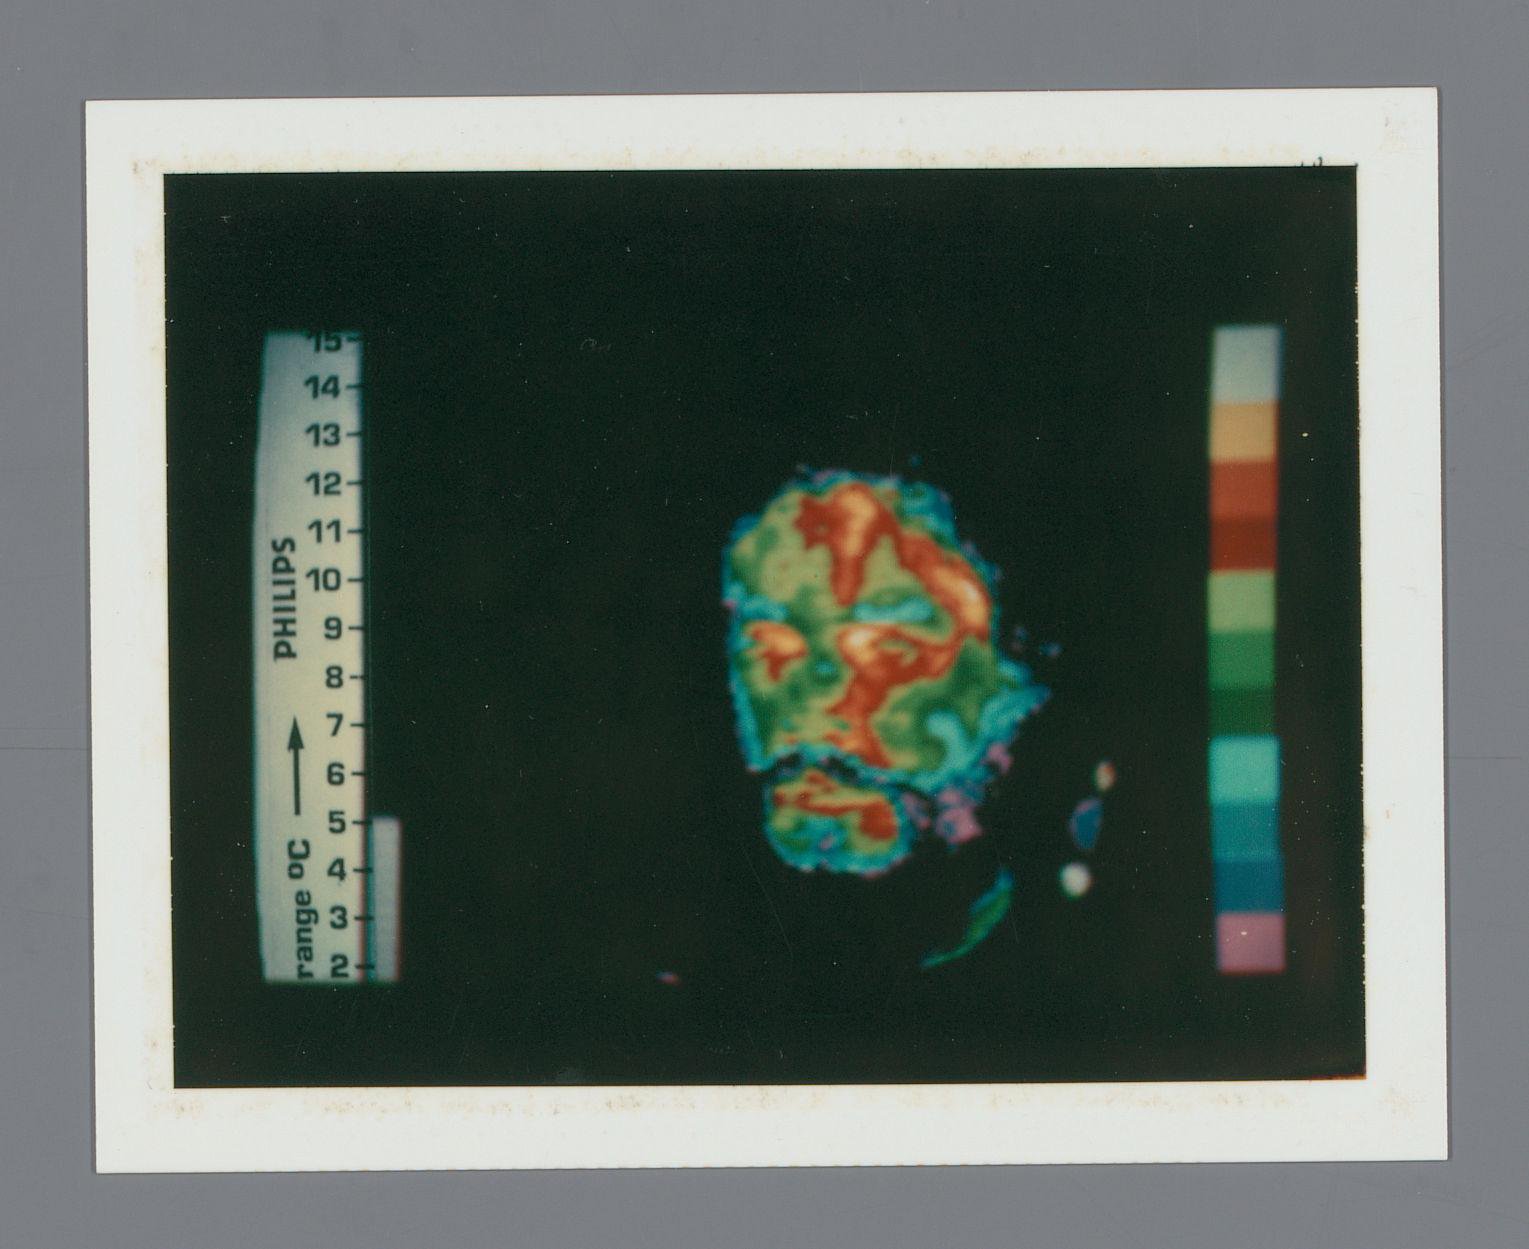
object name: instant photograph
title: Thermogram van een menselijk hoofd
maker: Anonymous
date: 1963-1984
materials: paper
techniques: peel apart (dye diffusion transfer print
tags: head (human)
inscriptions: number: ‘G78797PG’